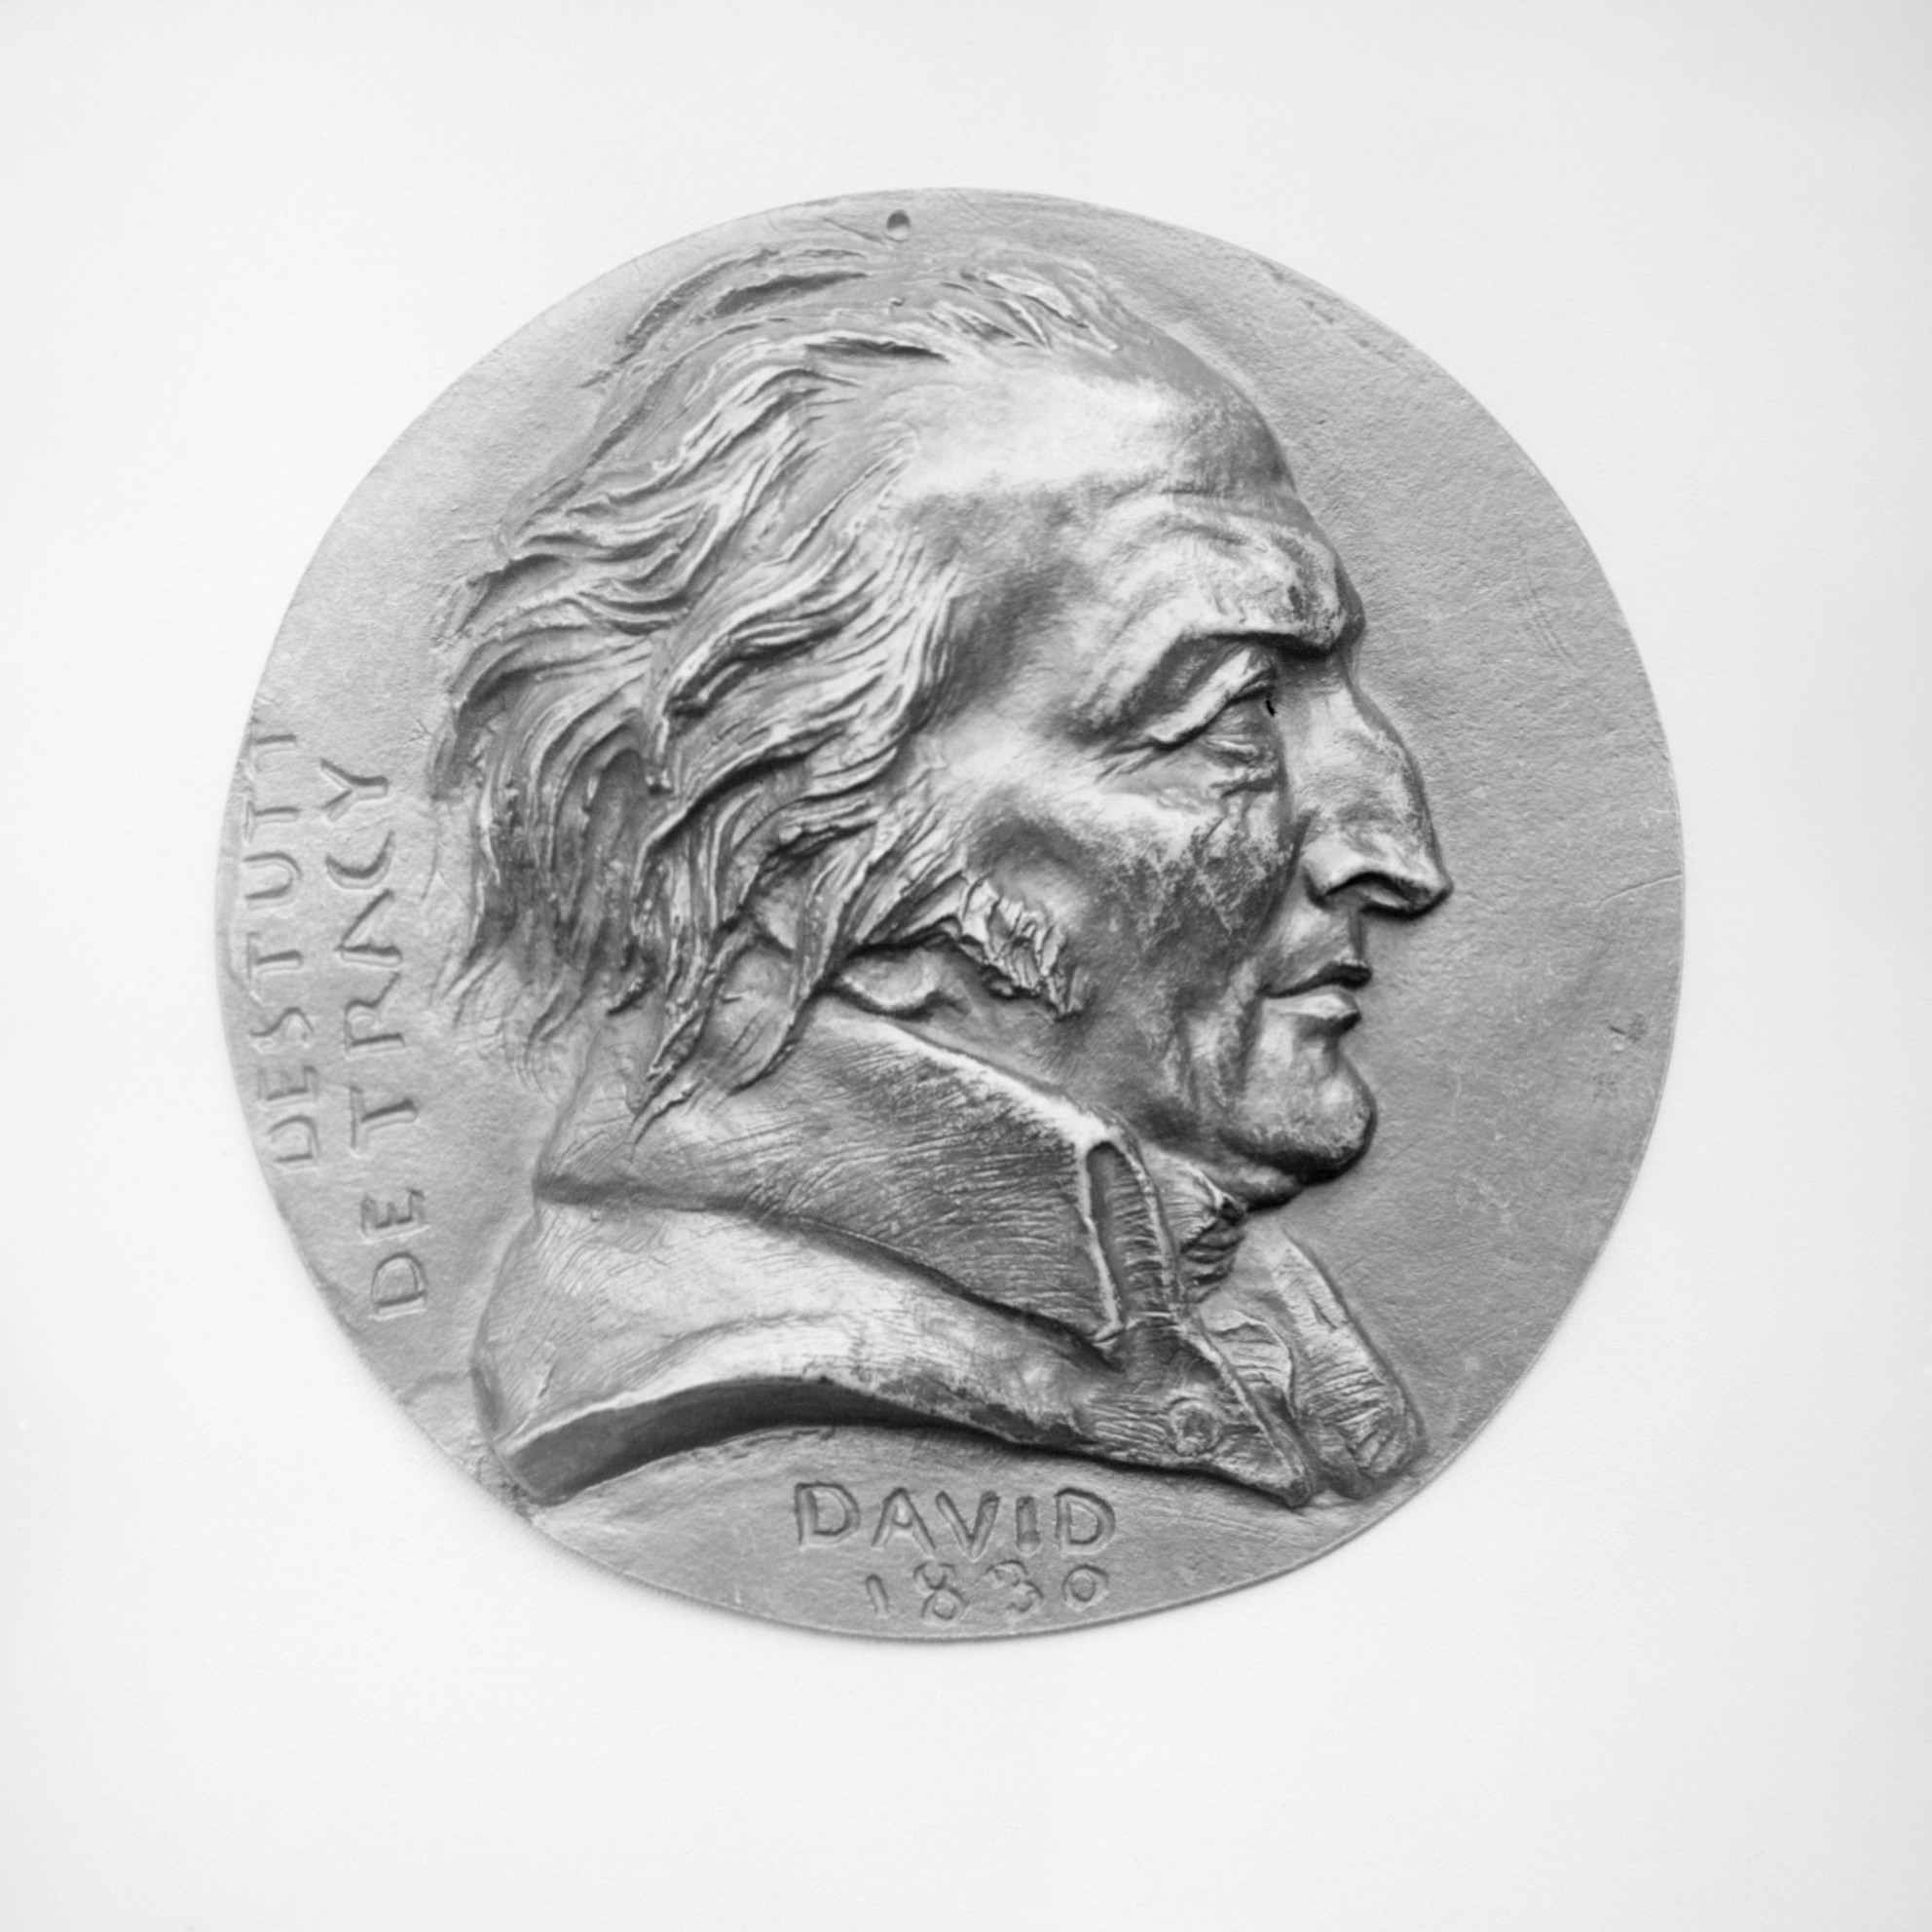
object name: medallion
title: Antoine Louis Claude Destutt de Tracy (1754–1836), French philosopher, Member of the Institute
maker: pierre jean david d'angers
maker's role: artist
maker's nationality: french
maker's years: 1788-1856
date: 1830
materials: bronze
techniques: casting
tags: men,profiles